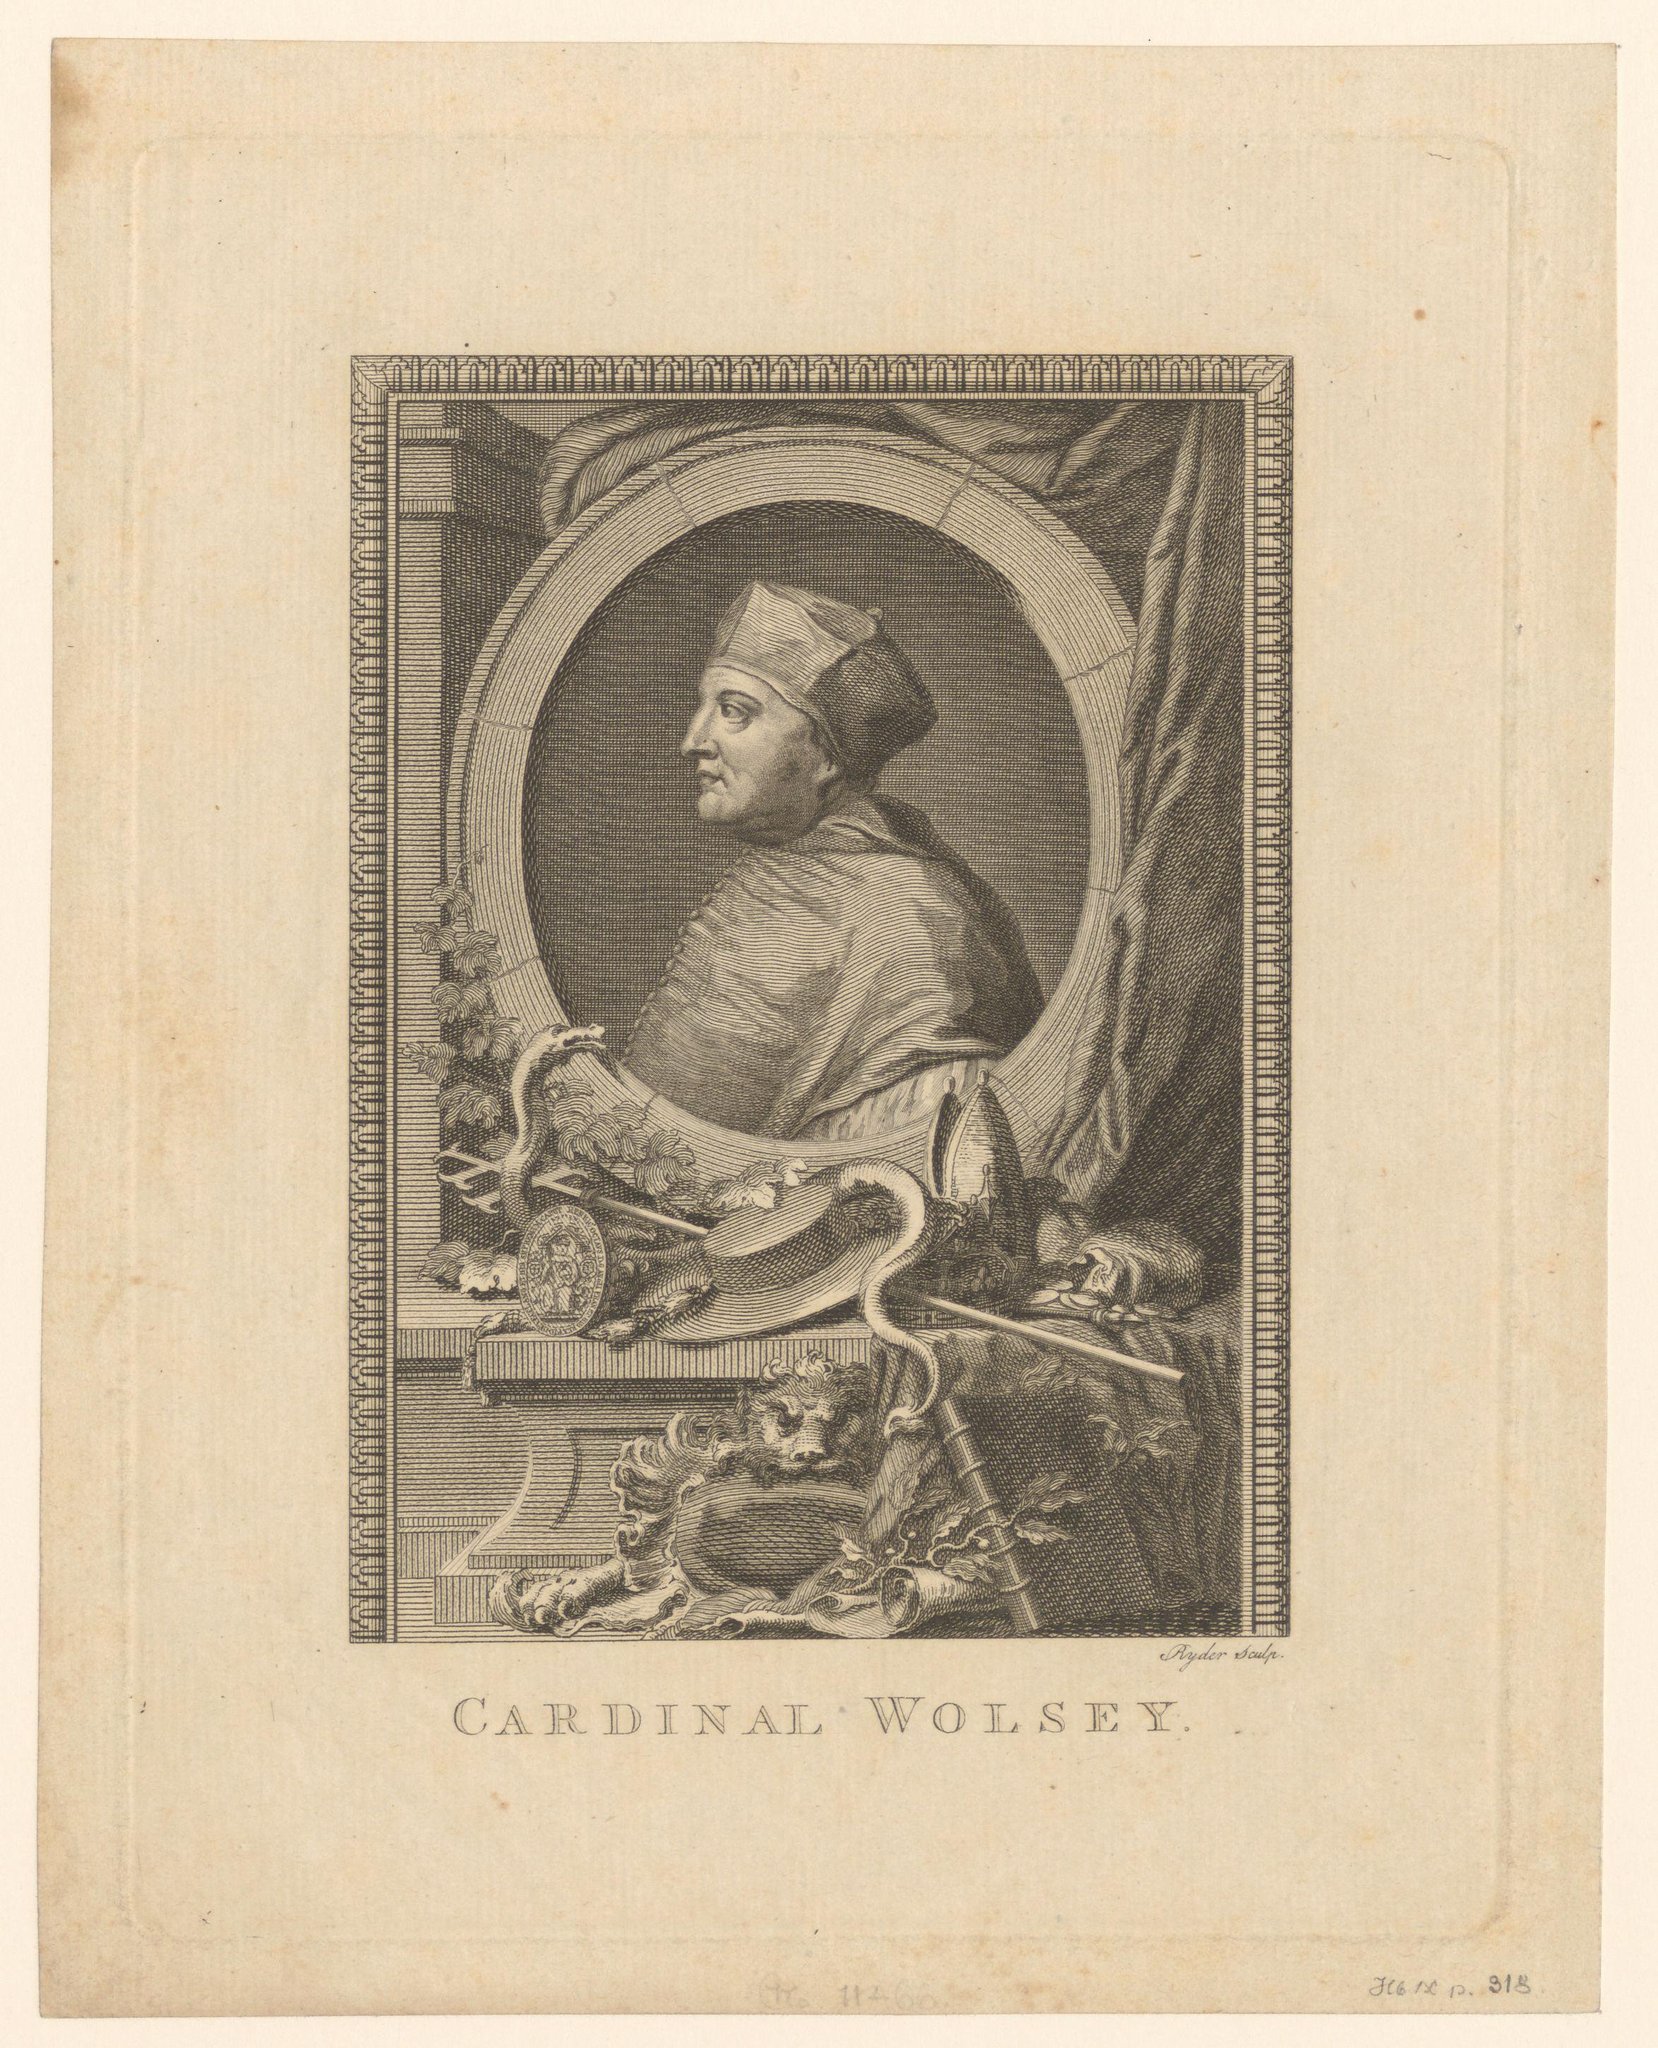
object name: print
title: Portret van Thomas Wolsey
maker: thomas ryder (i)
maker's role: print maker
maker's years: 1746-1810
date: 1756-1810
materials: paper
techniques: engraving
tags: cardinal, historical persons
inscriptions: collector's mark: Lugt 2228